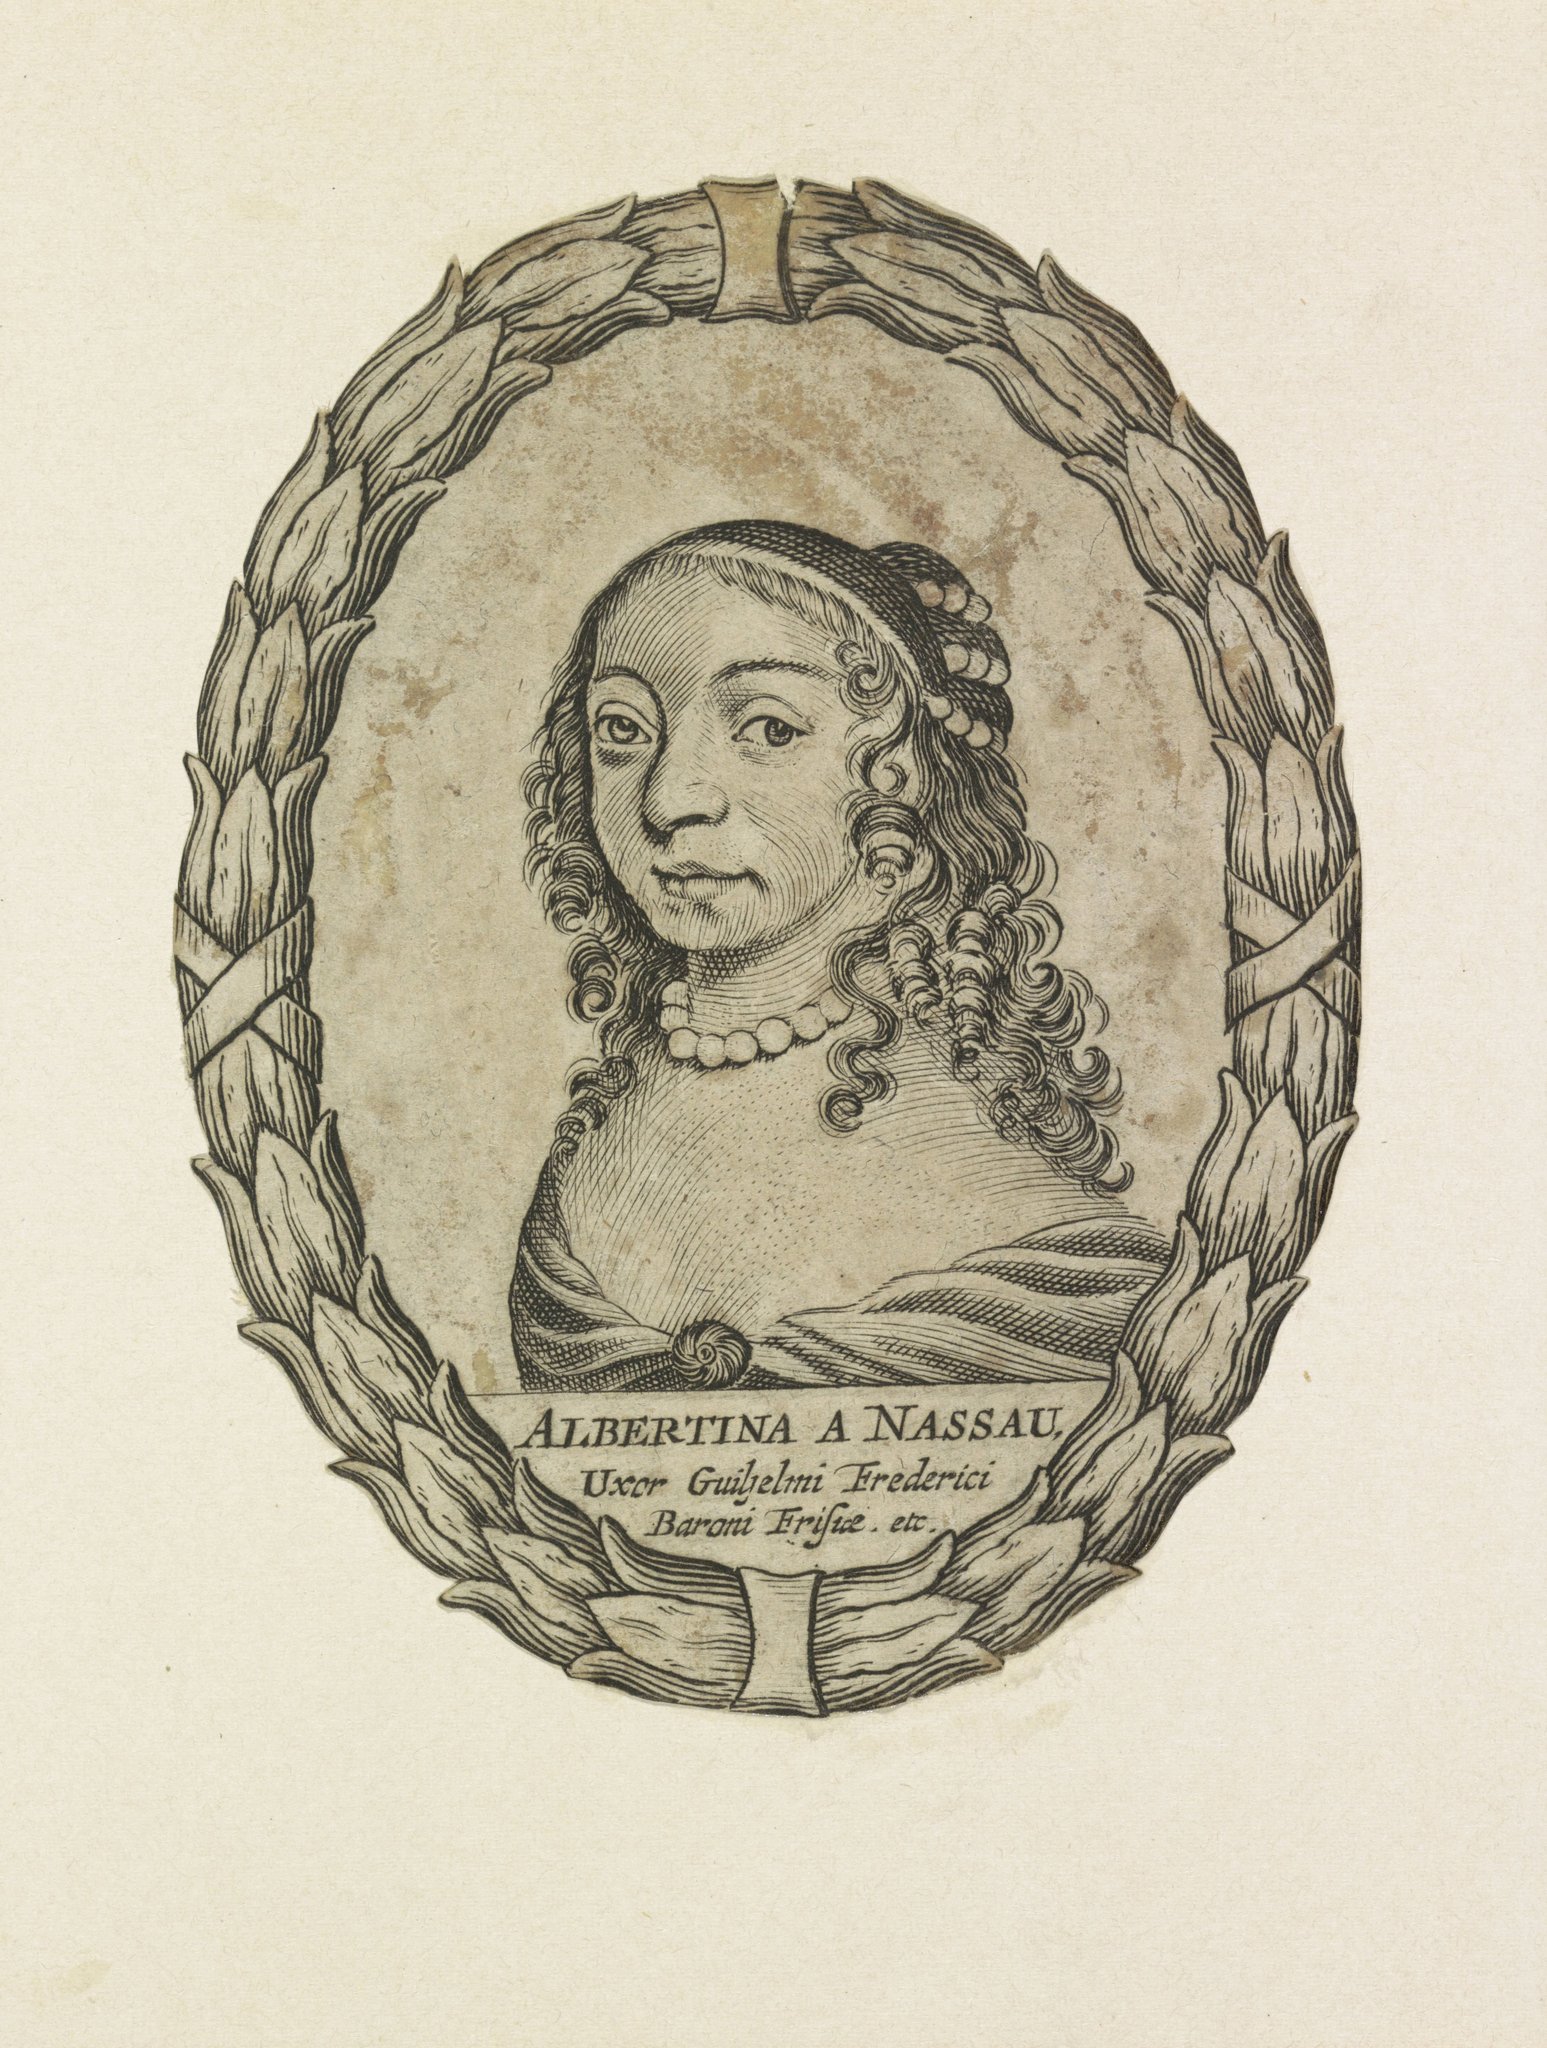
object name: print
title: Portret van Albertine Agnes, prinses van Oranje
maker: Anonymous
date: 1645-1699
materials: paper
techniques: engraving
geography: low countries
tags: albertine agnes (prinses van oranje)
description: De hier vermelde titel verwijst naar de hoogst verkregen titel van de geportretteerde, niet per se naar de titel die de geportretteerde op deze voorstelling draagt.